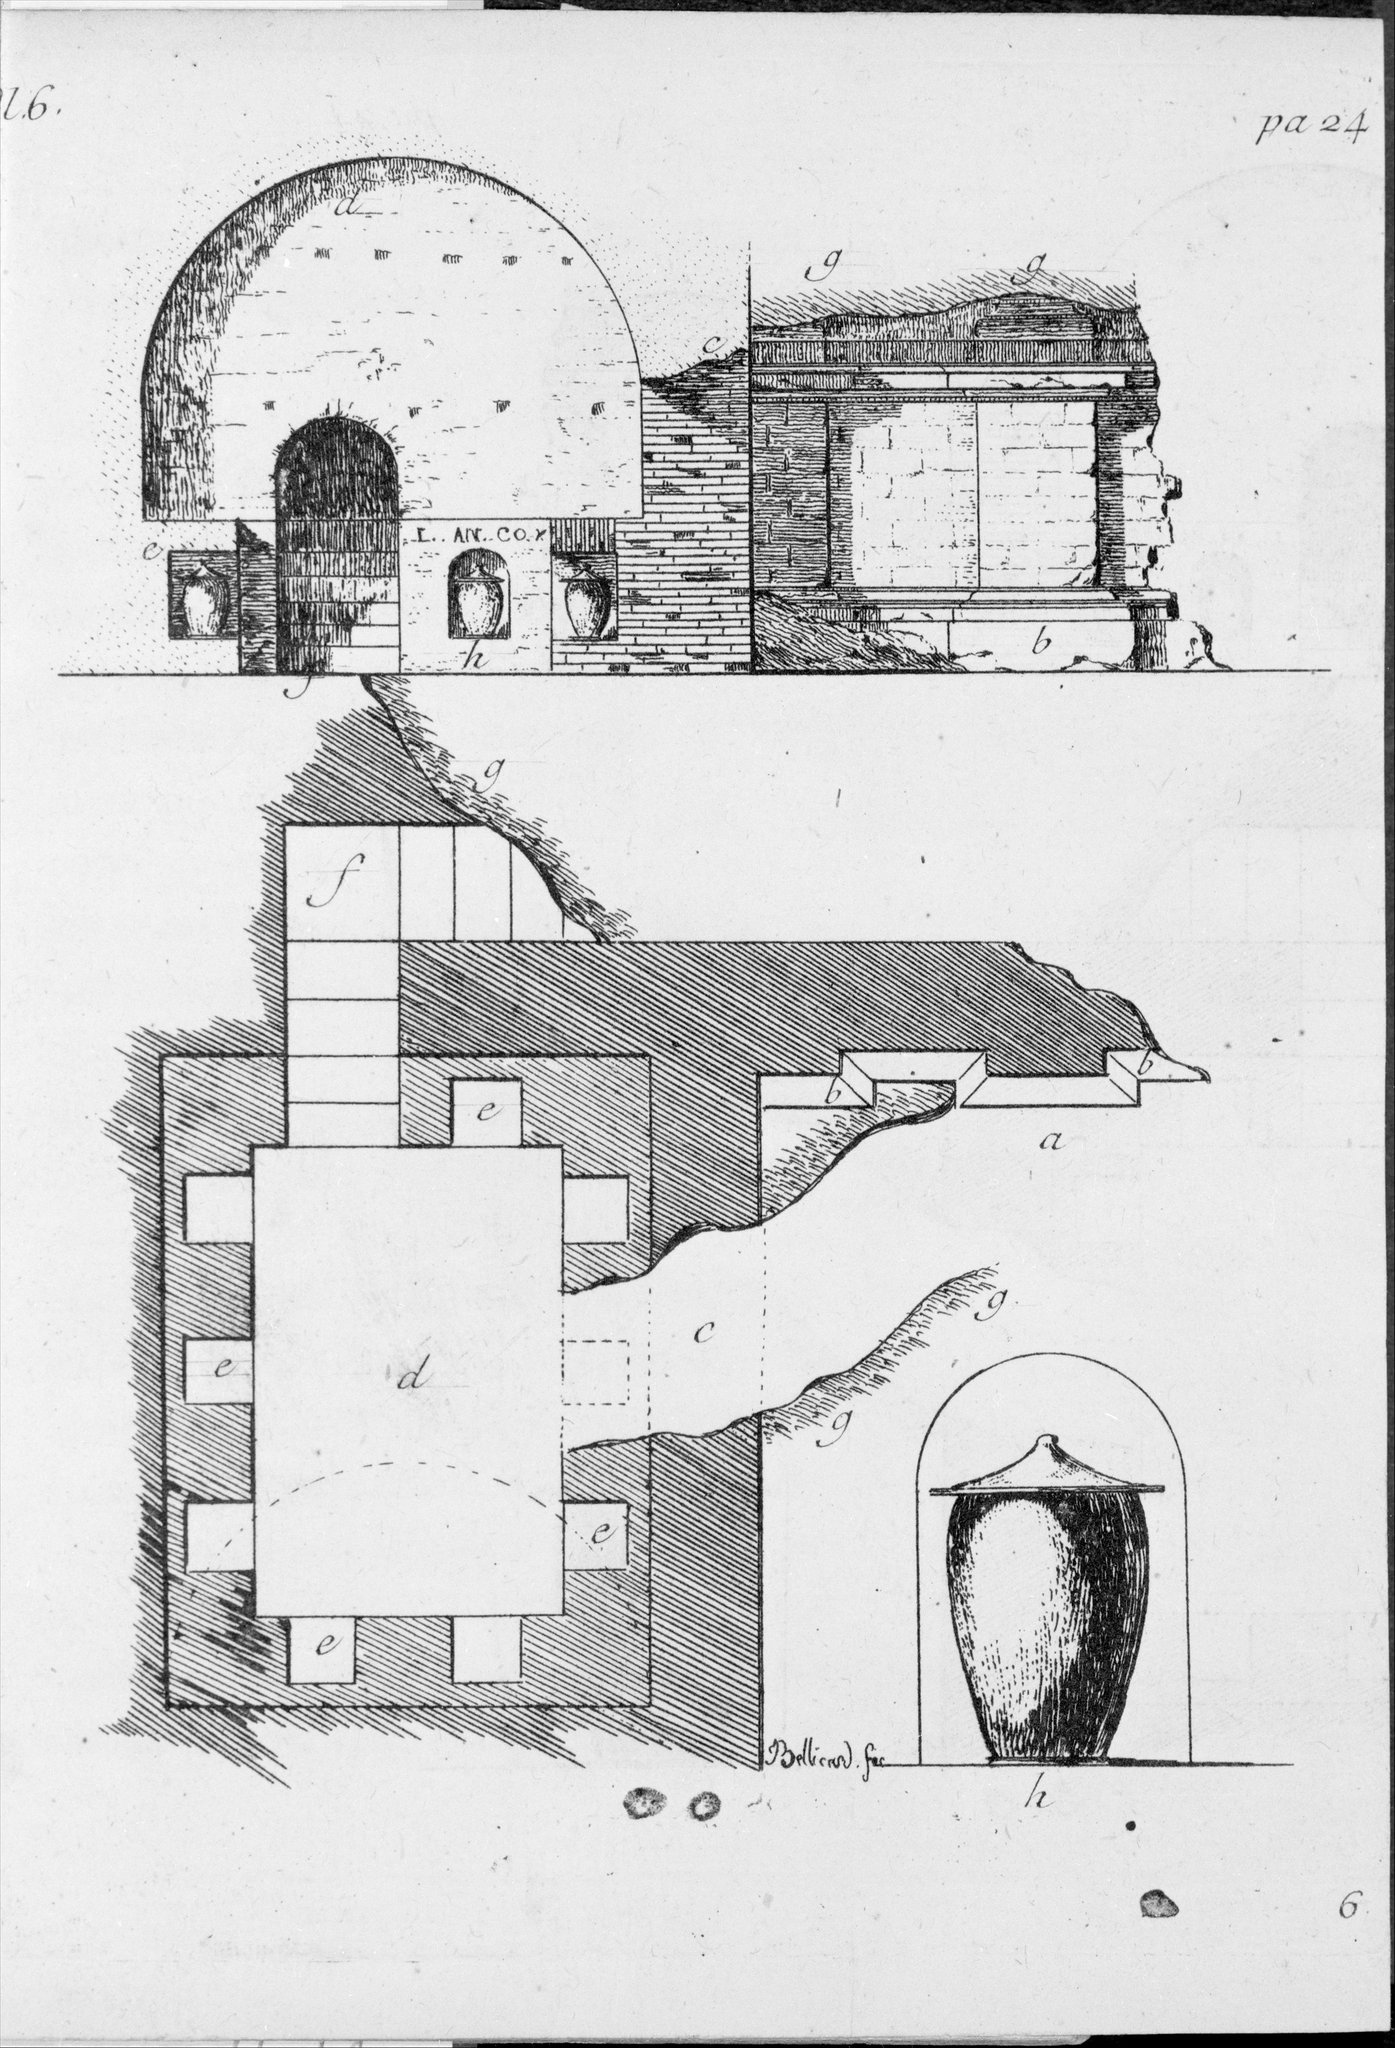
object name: book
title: Observations sur les antiquités de la ville d'Herculanum avec quelques reflexions sur la Peinture & la Sculpture des Anciens & une courte description de quelques Antiquités des environs de Naples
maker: charles nicolas cochin ii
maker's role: artist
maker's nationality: french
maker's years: 1715-1790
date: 1754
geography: france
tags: architecture